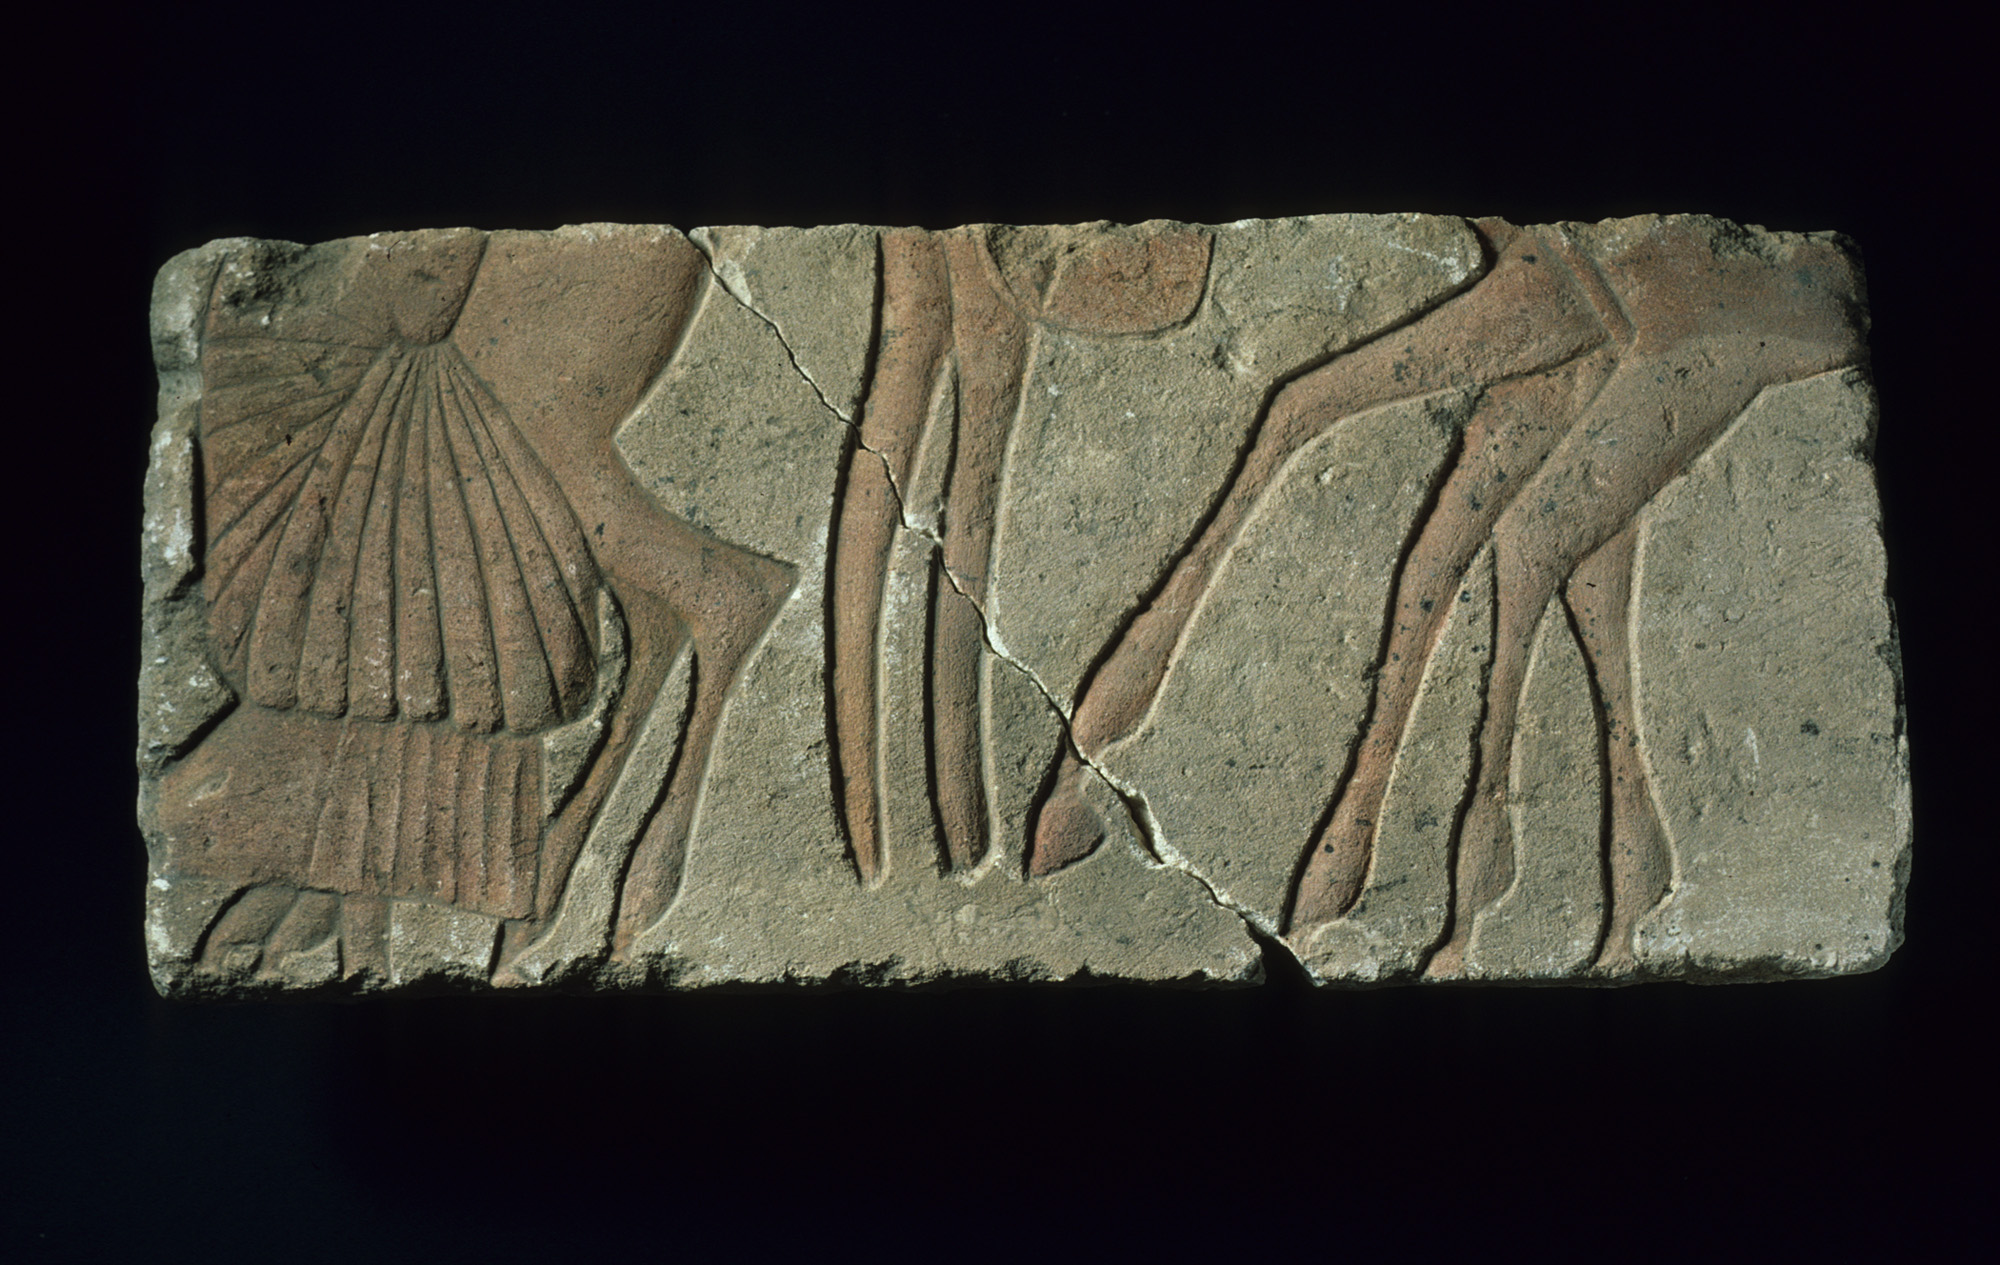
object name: talatat, horse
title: Relief with official and horses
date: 1353-1336 BCE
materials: limestone, paint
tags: horses